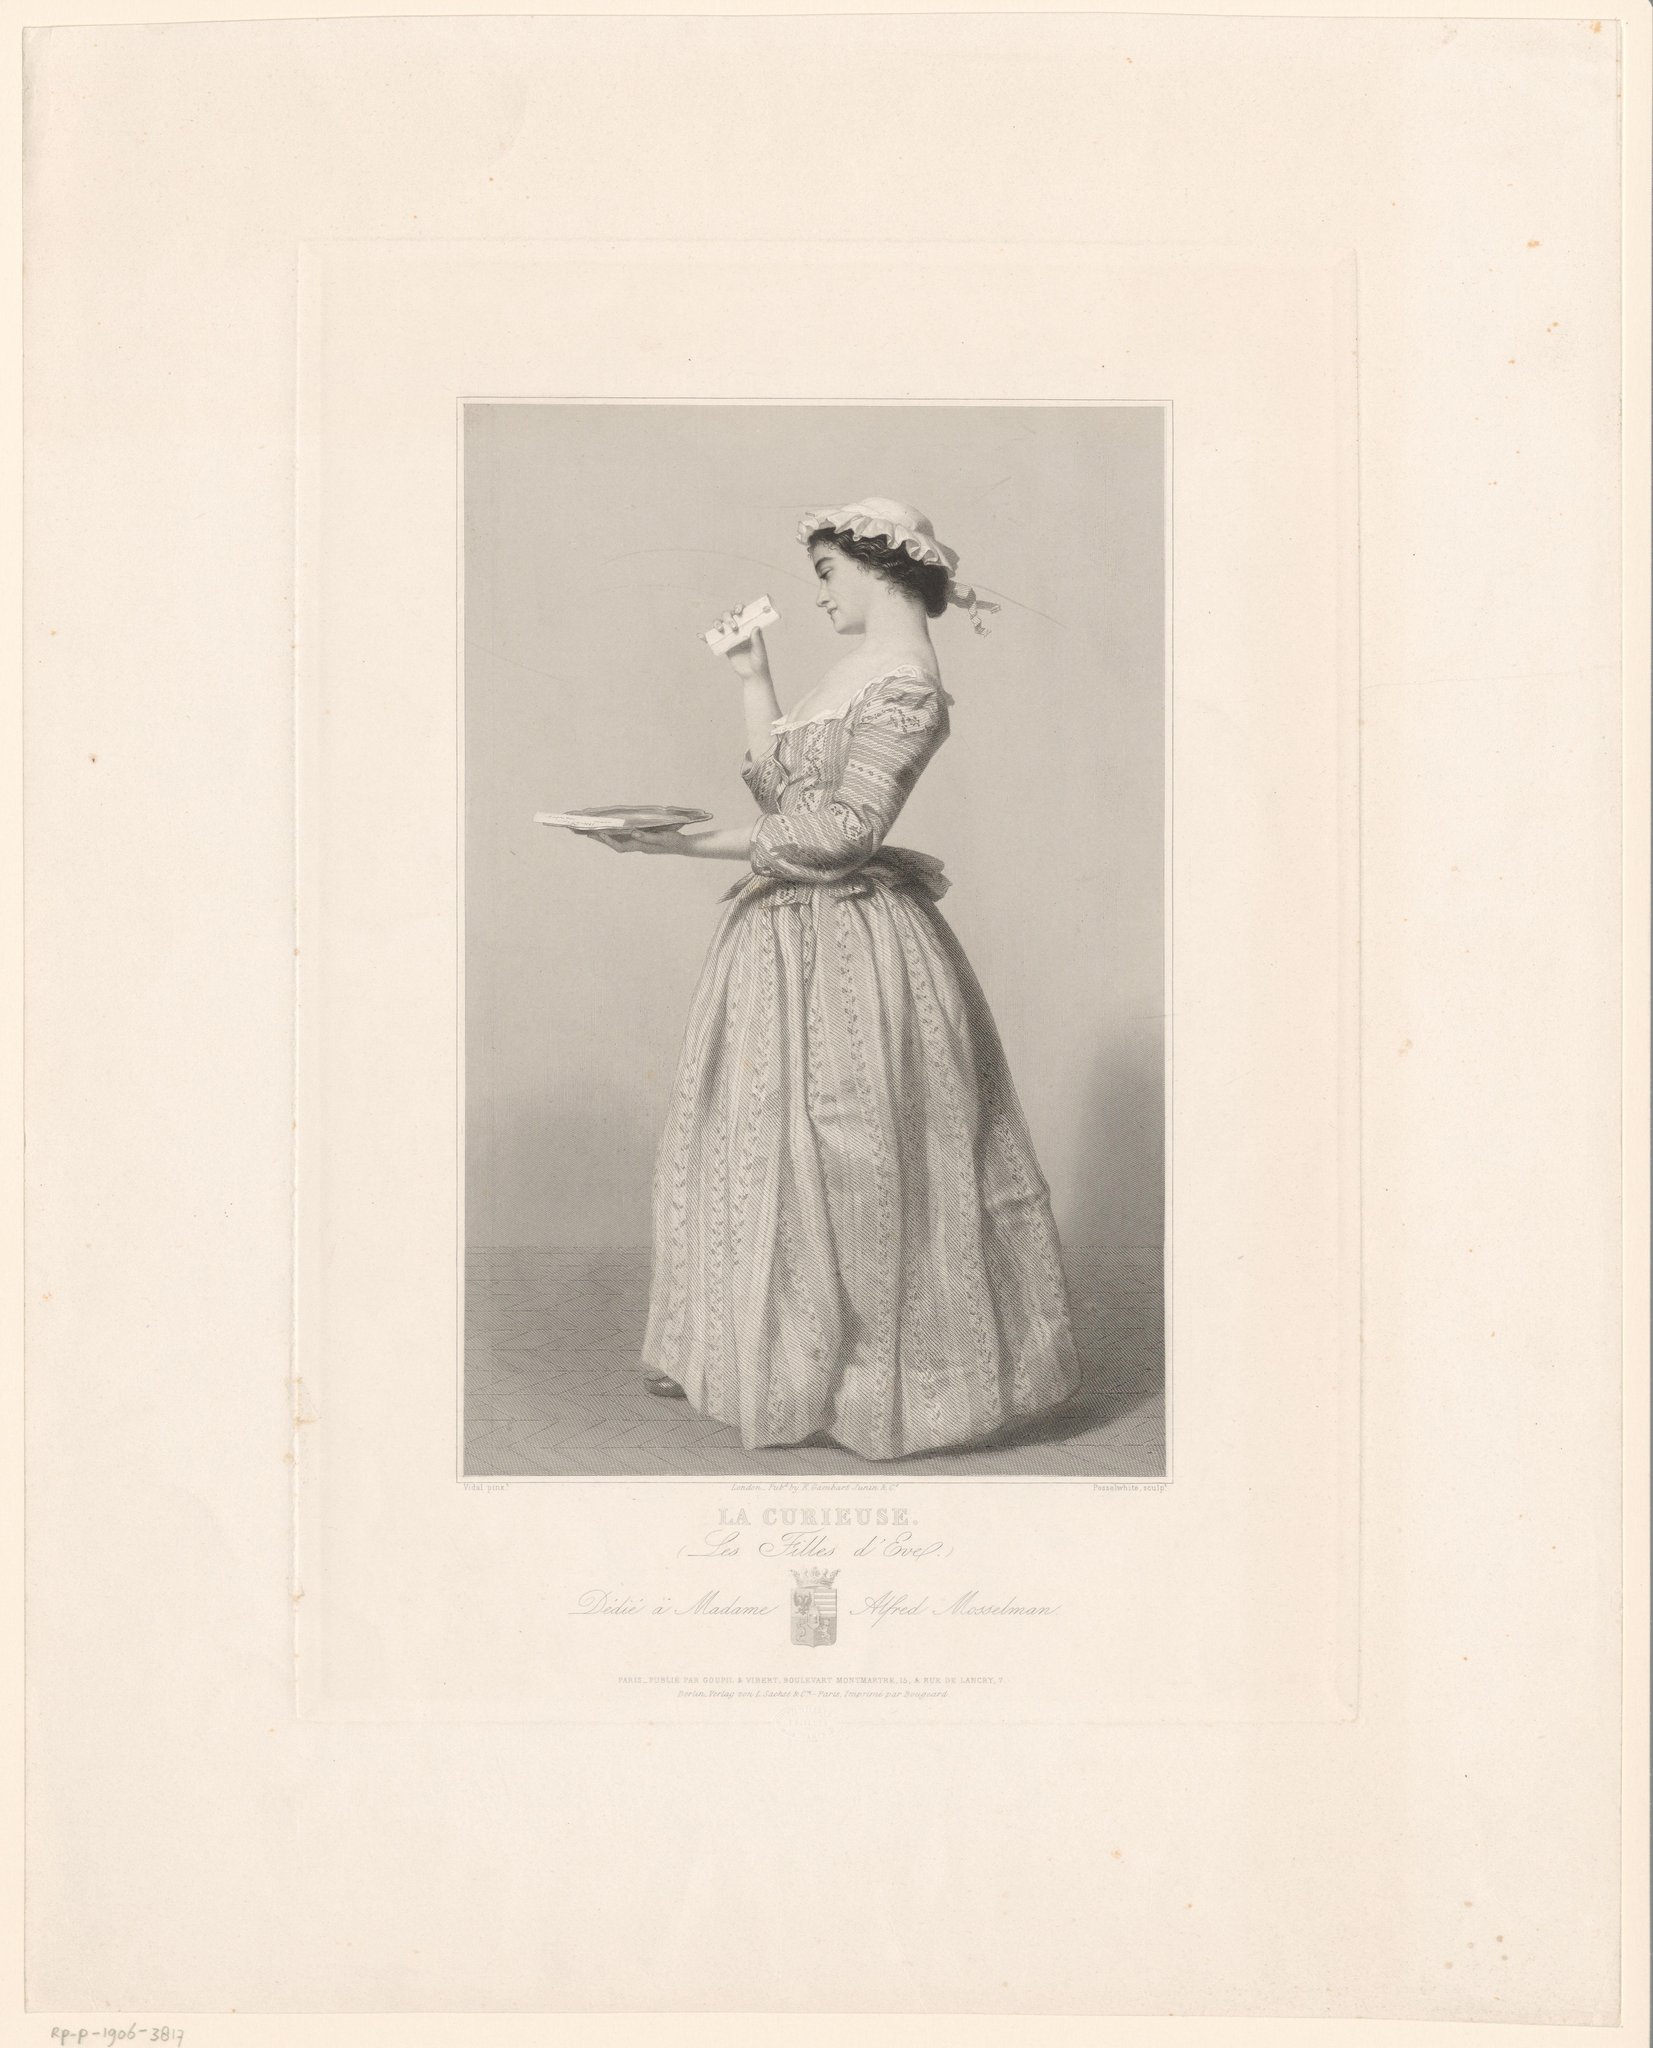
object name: print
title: La Curieuse (Les Filles d'Eve)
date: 1845-1877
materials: paper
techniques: engraving, etching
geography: london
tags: seal, stamp, letter, envelope, curiosity, inquisitiveness, desire of knowledge; 'curiosità' (ripa)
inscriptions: collector's mark: Lugt 2228